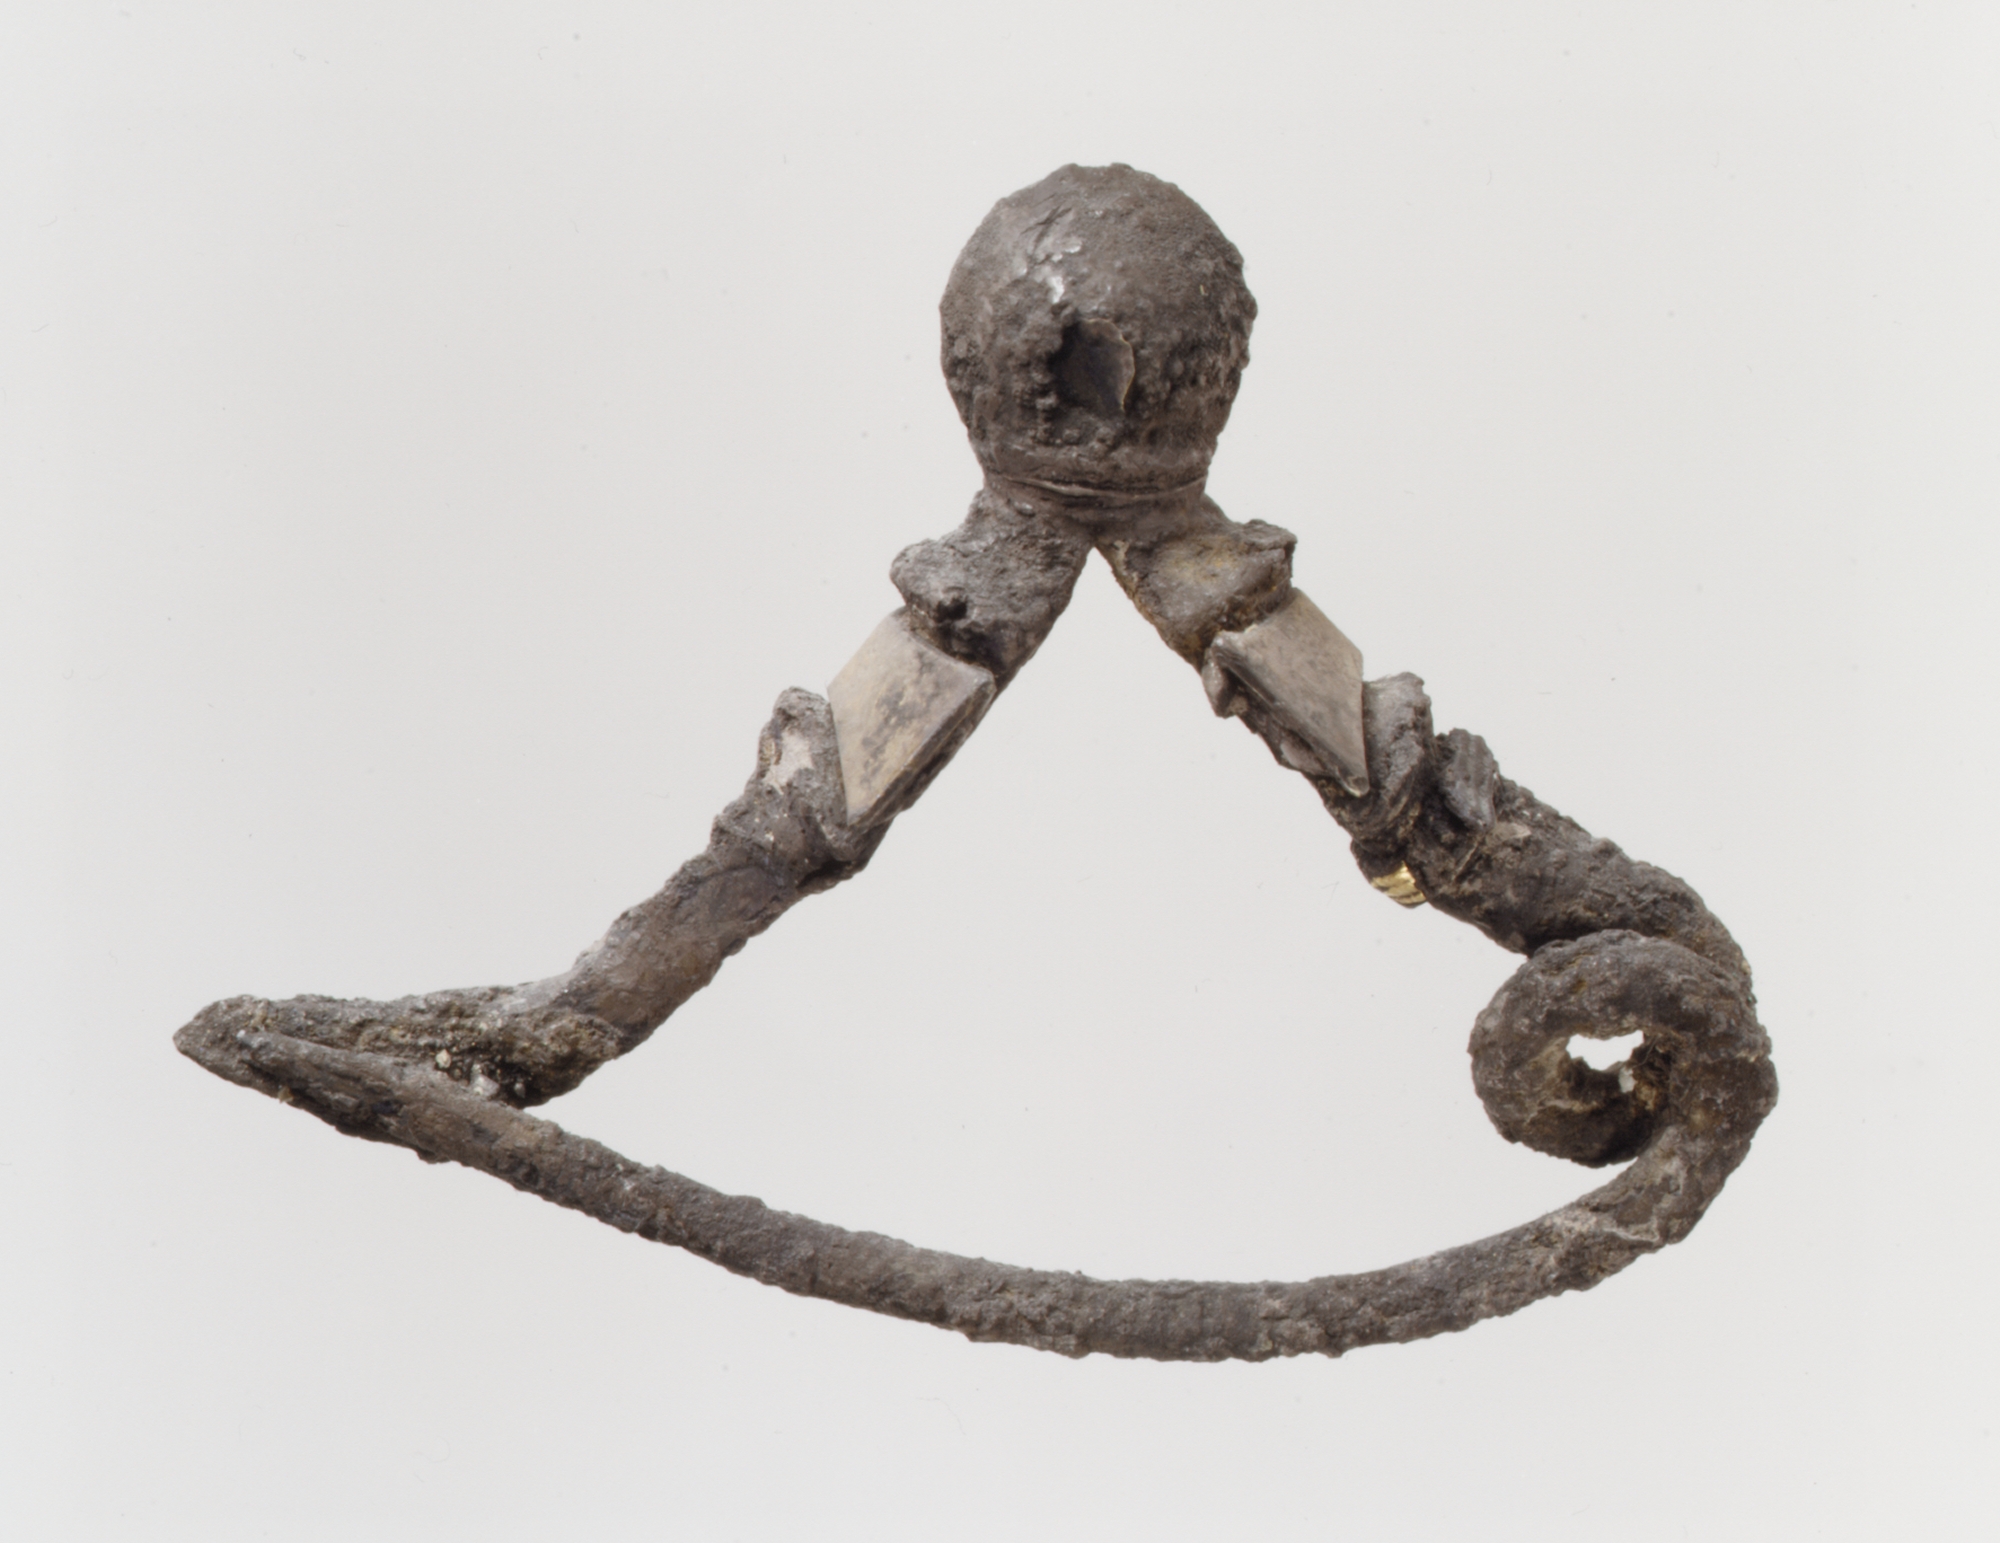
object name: fibula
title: Silver-gilt fibula (safety pin)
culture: cypriot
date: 800-601 BCE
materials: silver